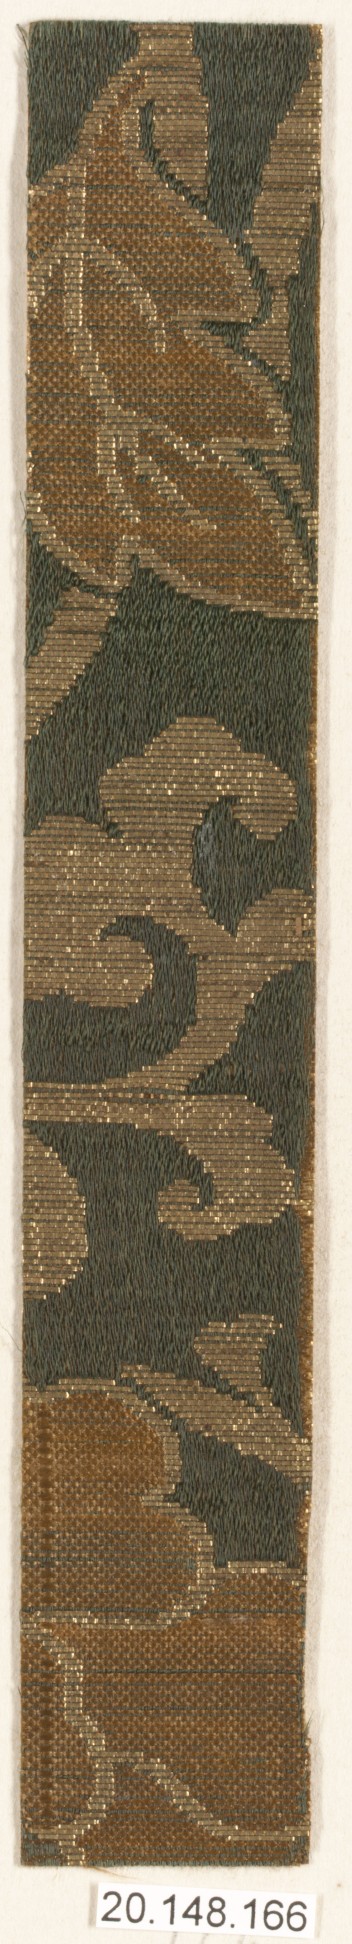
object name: piece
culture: japanese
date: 1601-1700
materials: silk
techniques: compound weave